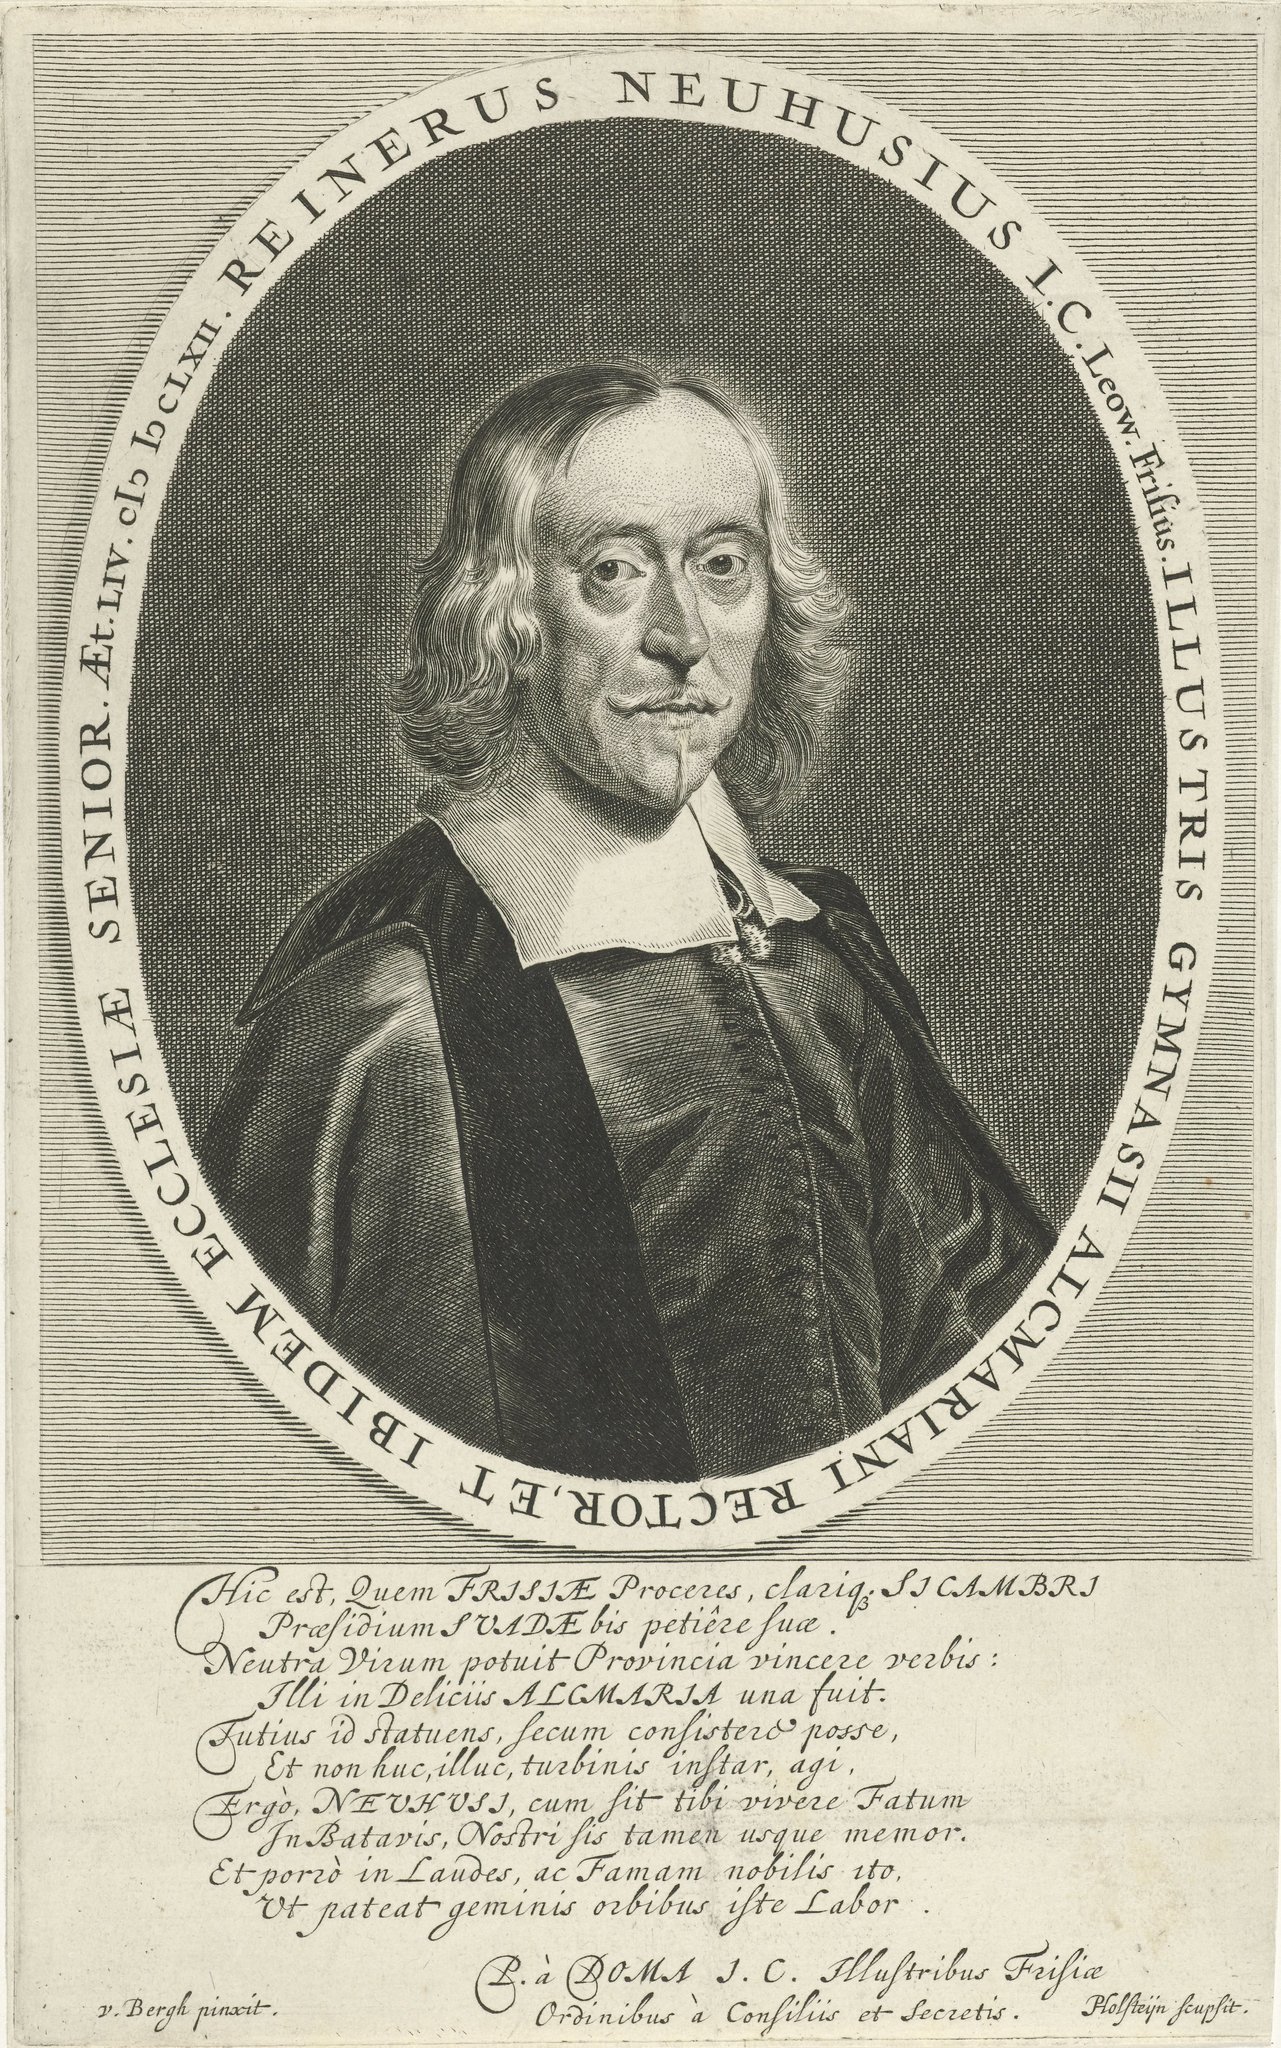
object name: print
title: Portret van Reinier Neuhusius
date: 1662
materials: paper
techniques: engraving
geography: northern netherlands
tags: reinier neuhusius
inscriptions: collector's mark: Lugt 2228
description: Portret naar rechts van Reinier Neuhusius op 62-jarige leeftijd in een ovaal met randschrift in het Latijn. Onder het portret tien regels in het Latijn.